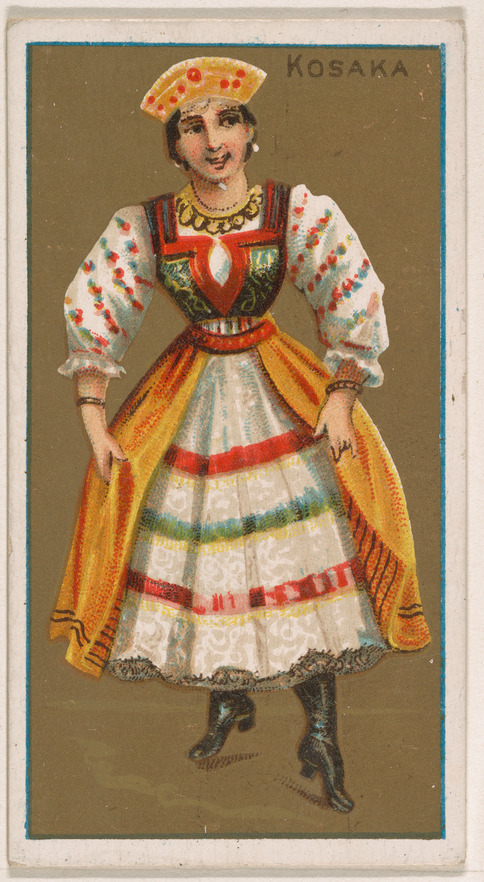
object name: print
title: Kosaka, from National Dances (N225, Type 1) issued by Kinney Bros.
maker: kinney brothers tobacco company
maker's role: publisher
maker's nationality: american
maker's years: 1869-2011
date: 1889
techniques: color lithograph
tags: women,dancing,dancers